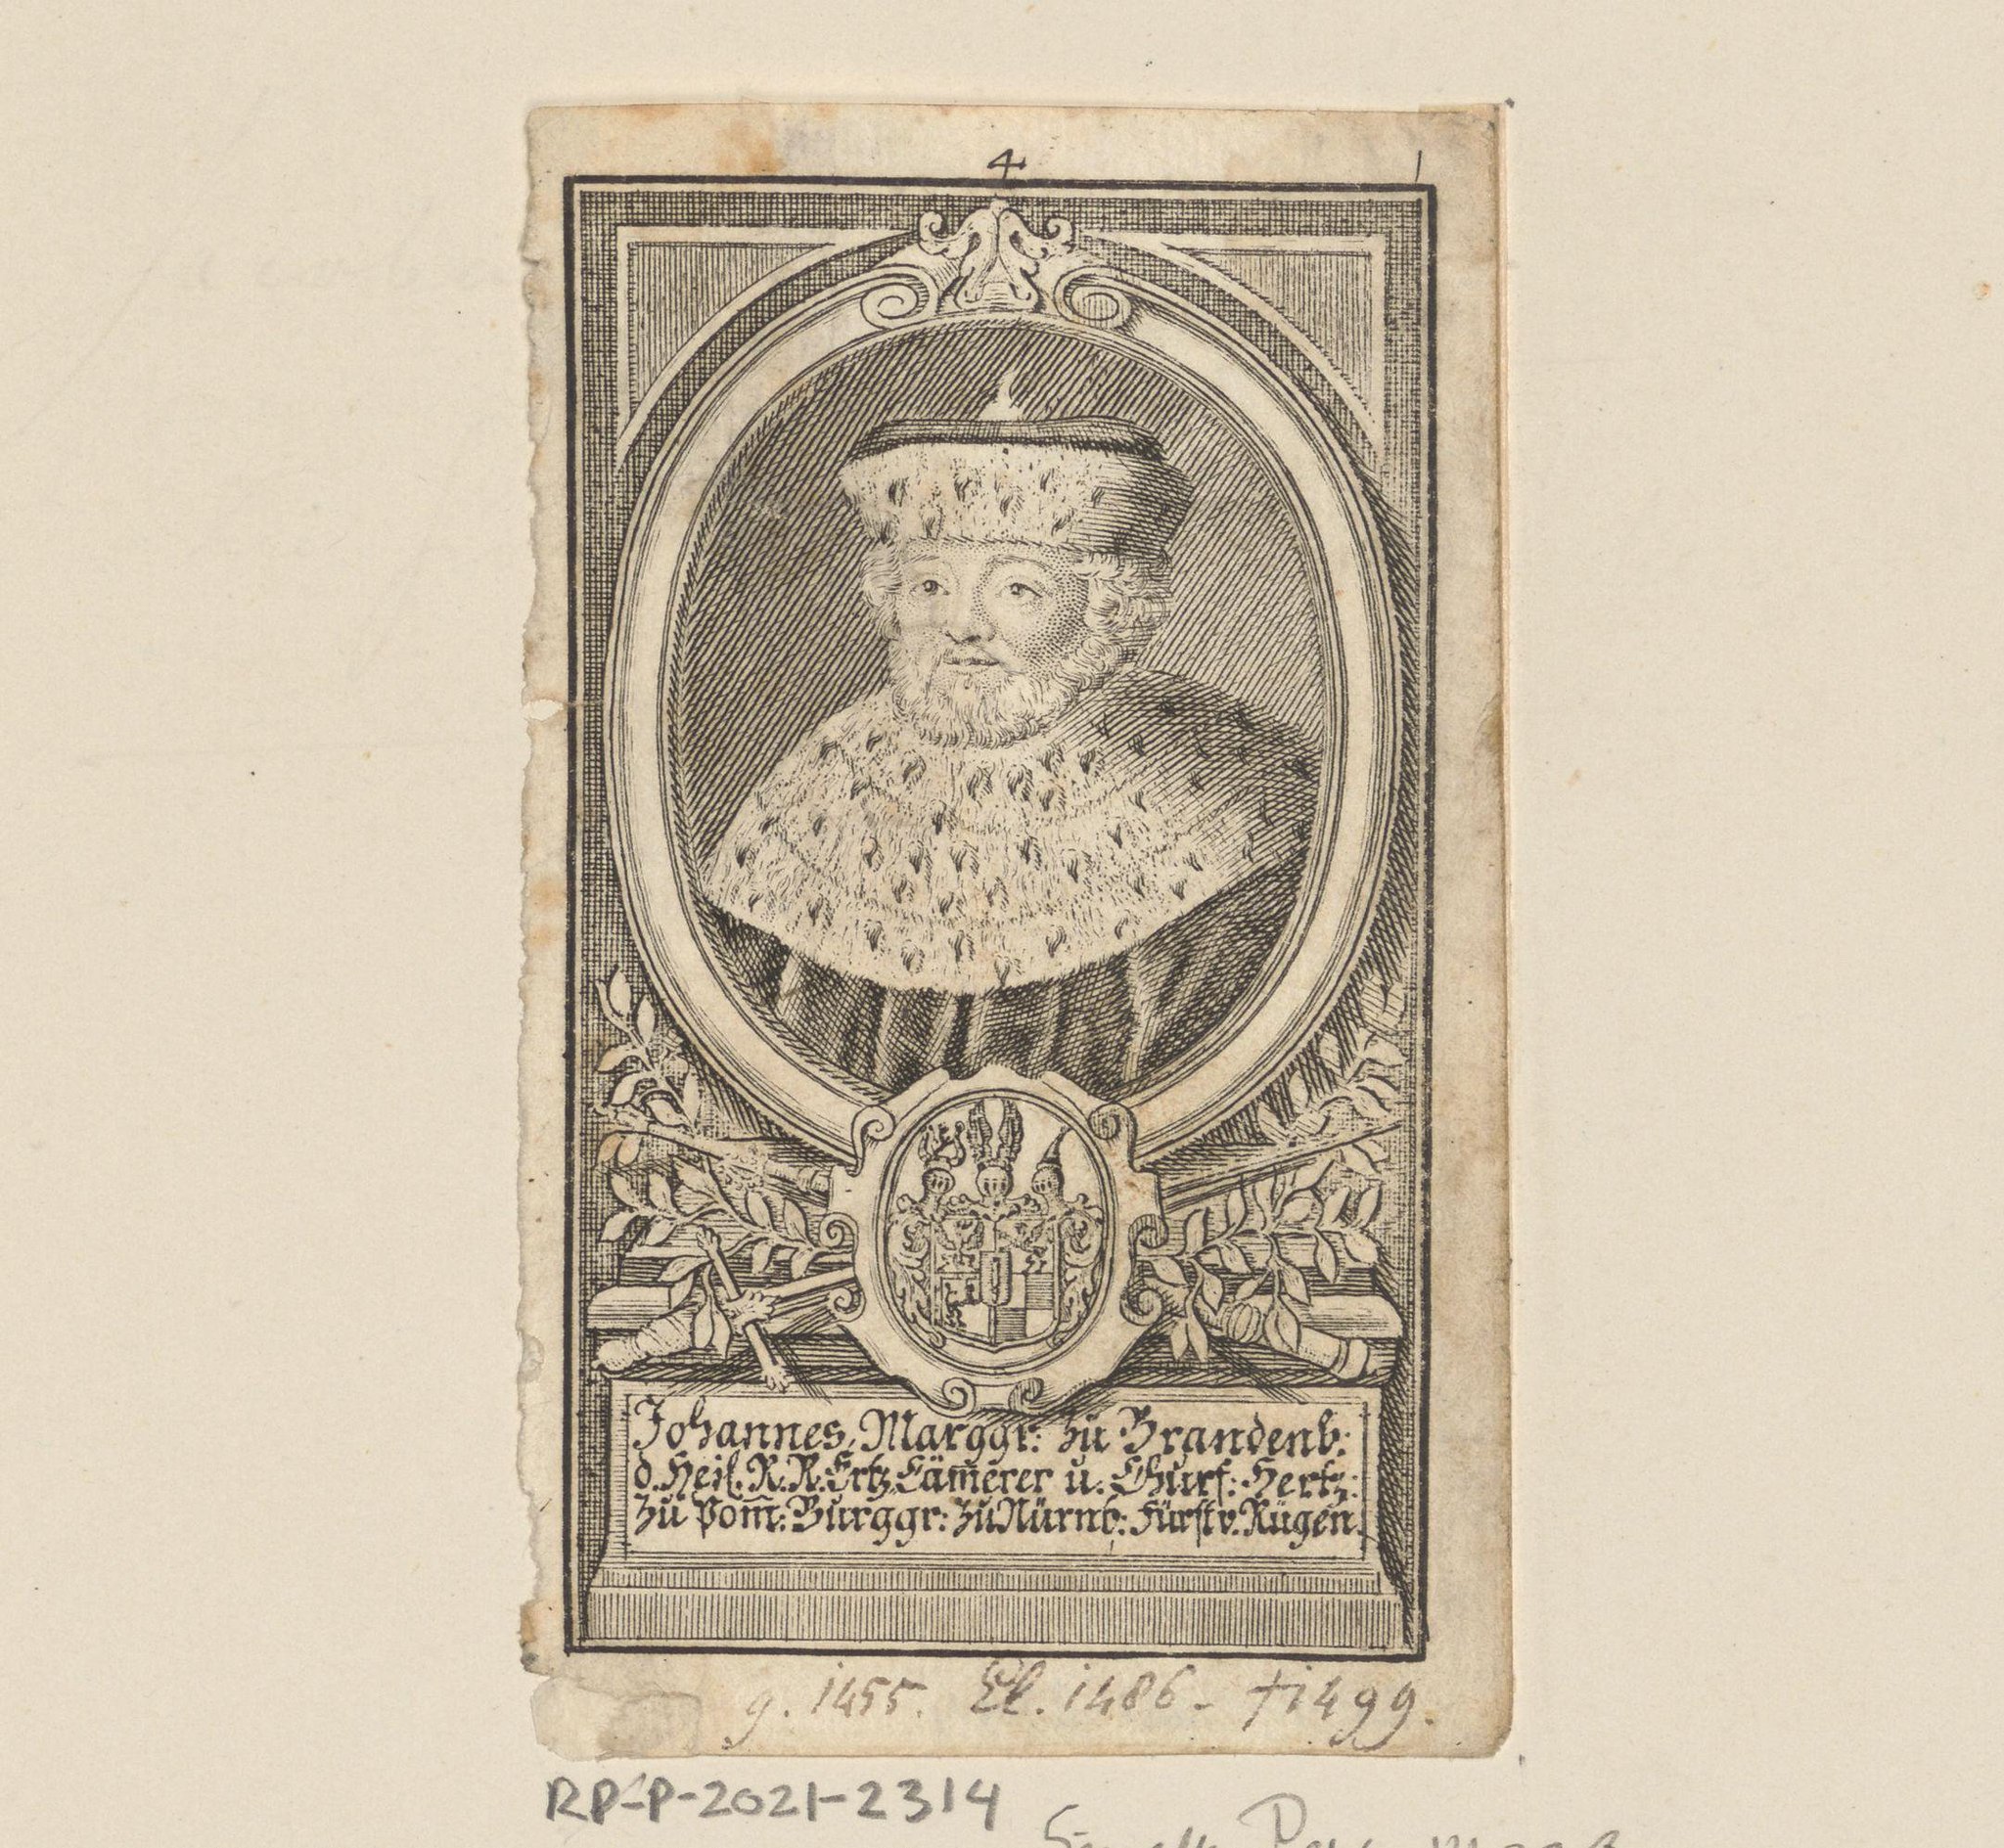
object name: print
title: Portret van Johann Cicero van Brandenburg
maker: Anonymous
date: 1650-1749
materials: paper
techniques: engraving, etching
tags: historical persons, ruler, sovereign, armorial bearing, heraldry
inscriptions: inscription: ‘480’